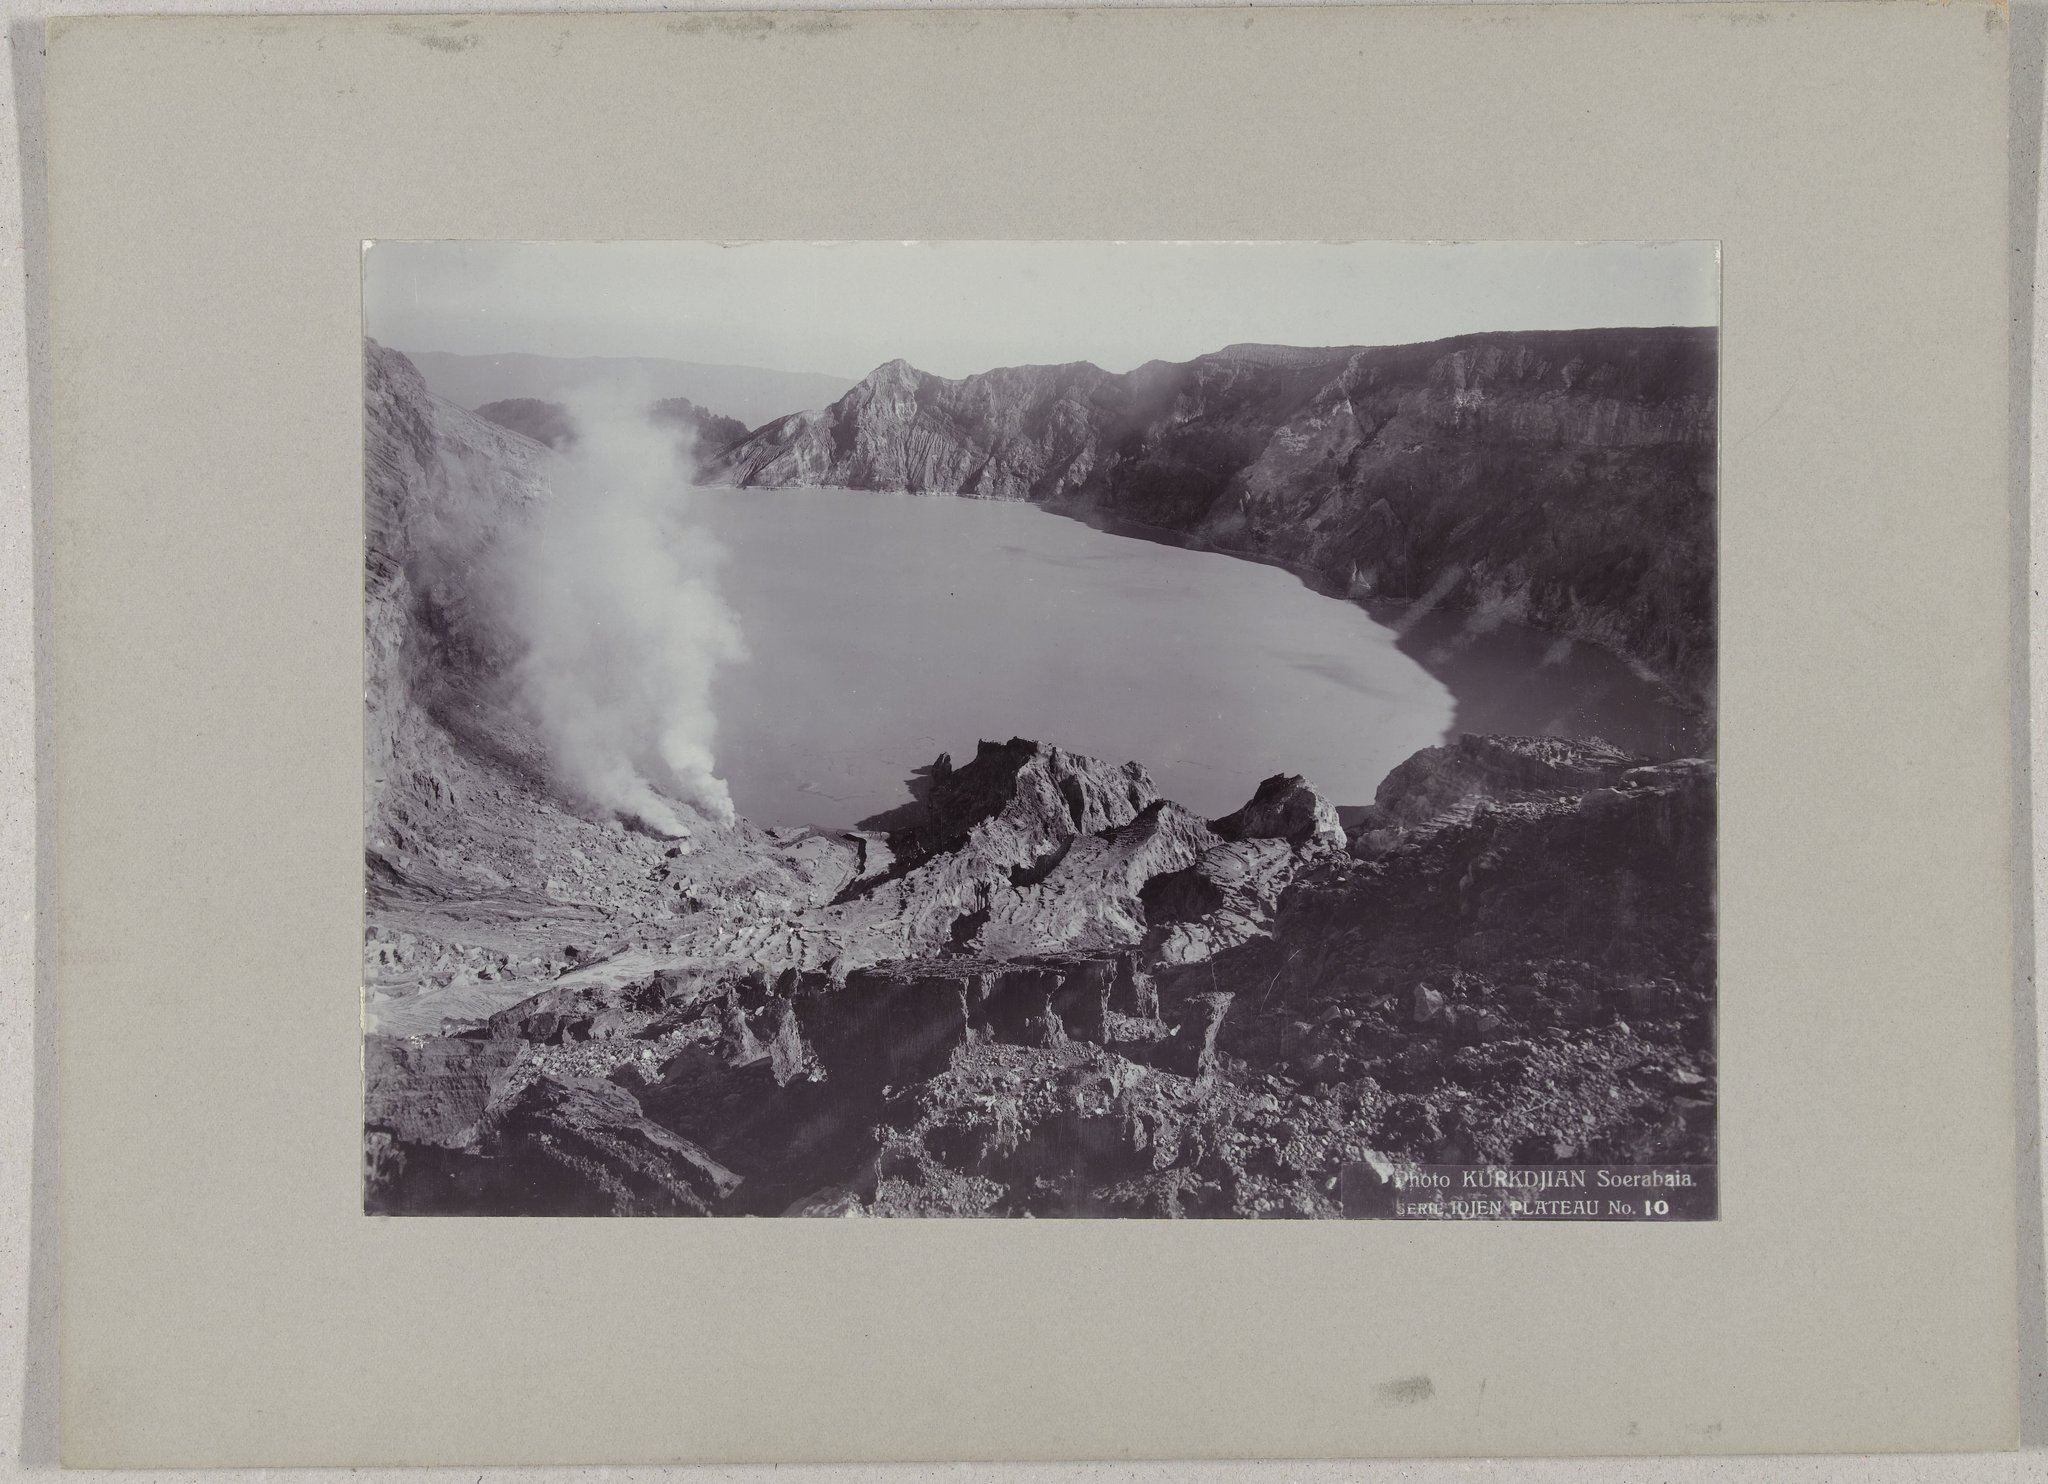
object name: photograph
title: Photo Kurkdjian Soerabaia / Serie Idjen Plateau No. 10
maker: onnes kurkdjian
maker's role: fotograaf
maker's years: 1851-1903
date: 1895-1915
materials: cardboard, paper, photographic support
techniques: gelatin silver print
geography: java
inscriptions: number: ‘97’, name: ‘Photo Kurkdjian Soerabaia / Serie Idjen Plateau No. 10’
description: Kratermeer op het Idjen Plateau, Java, Nederlands-Indië